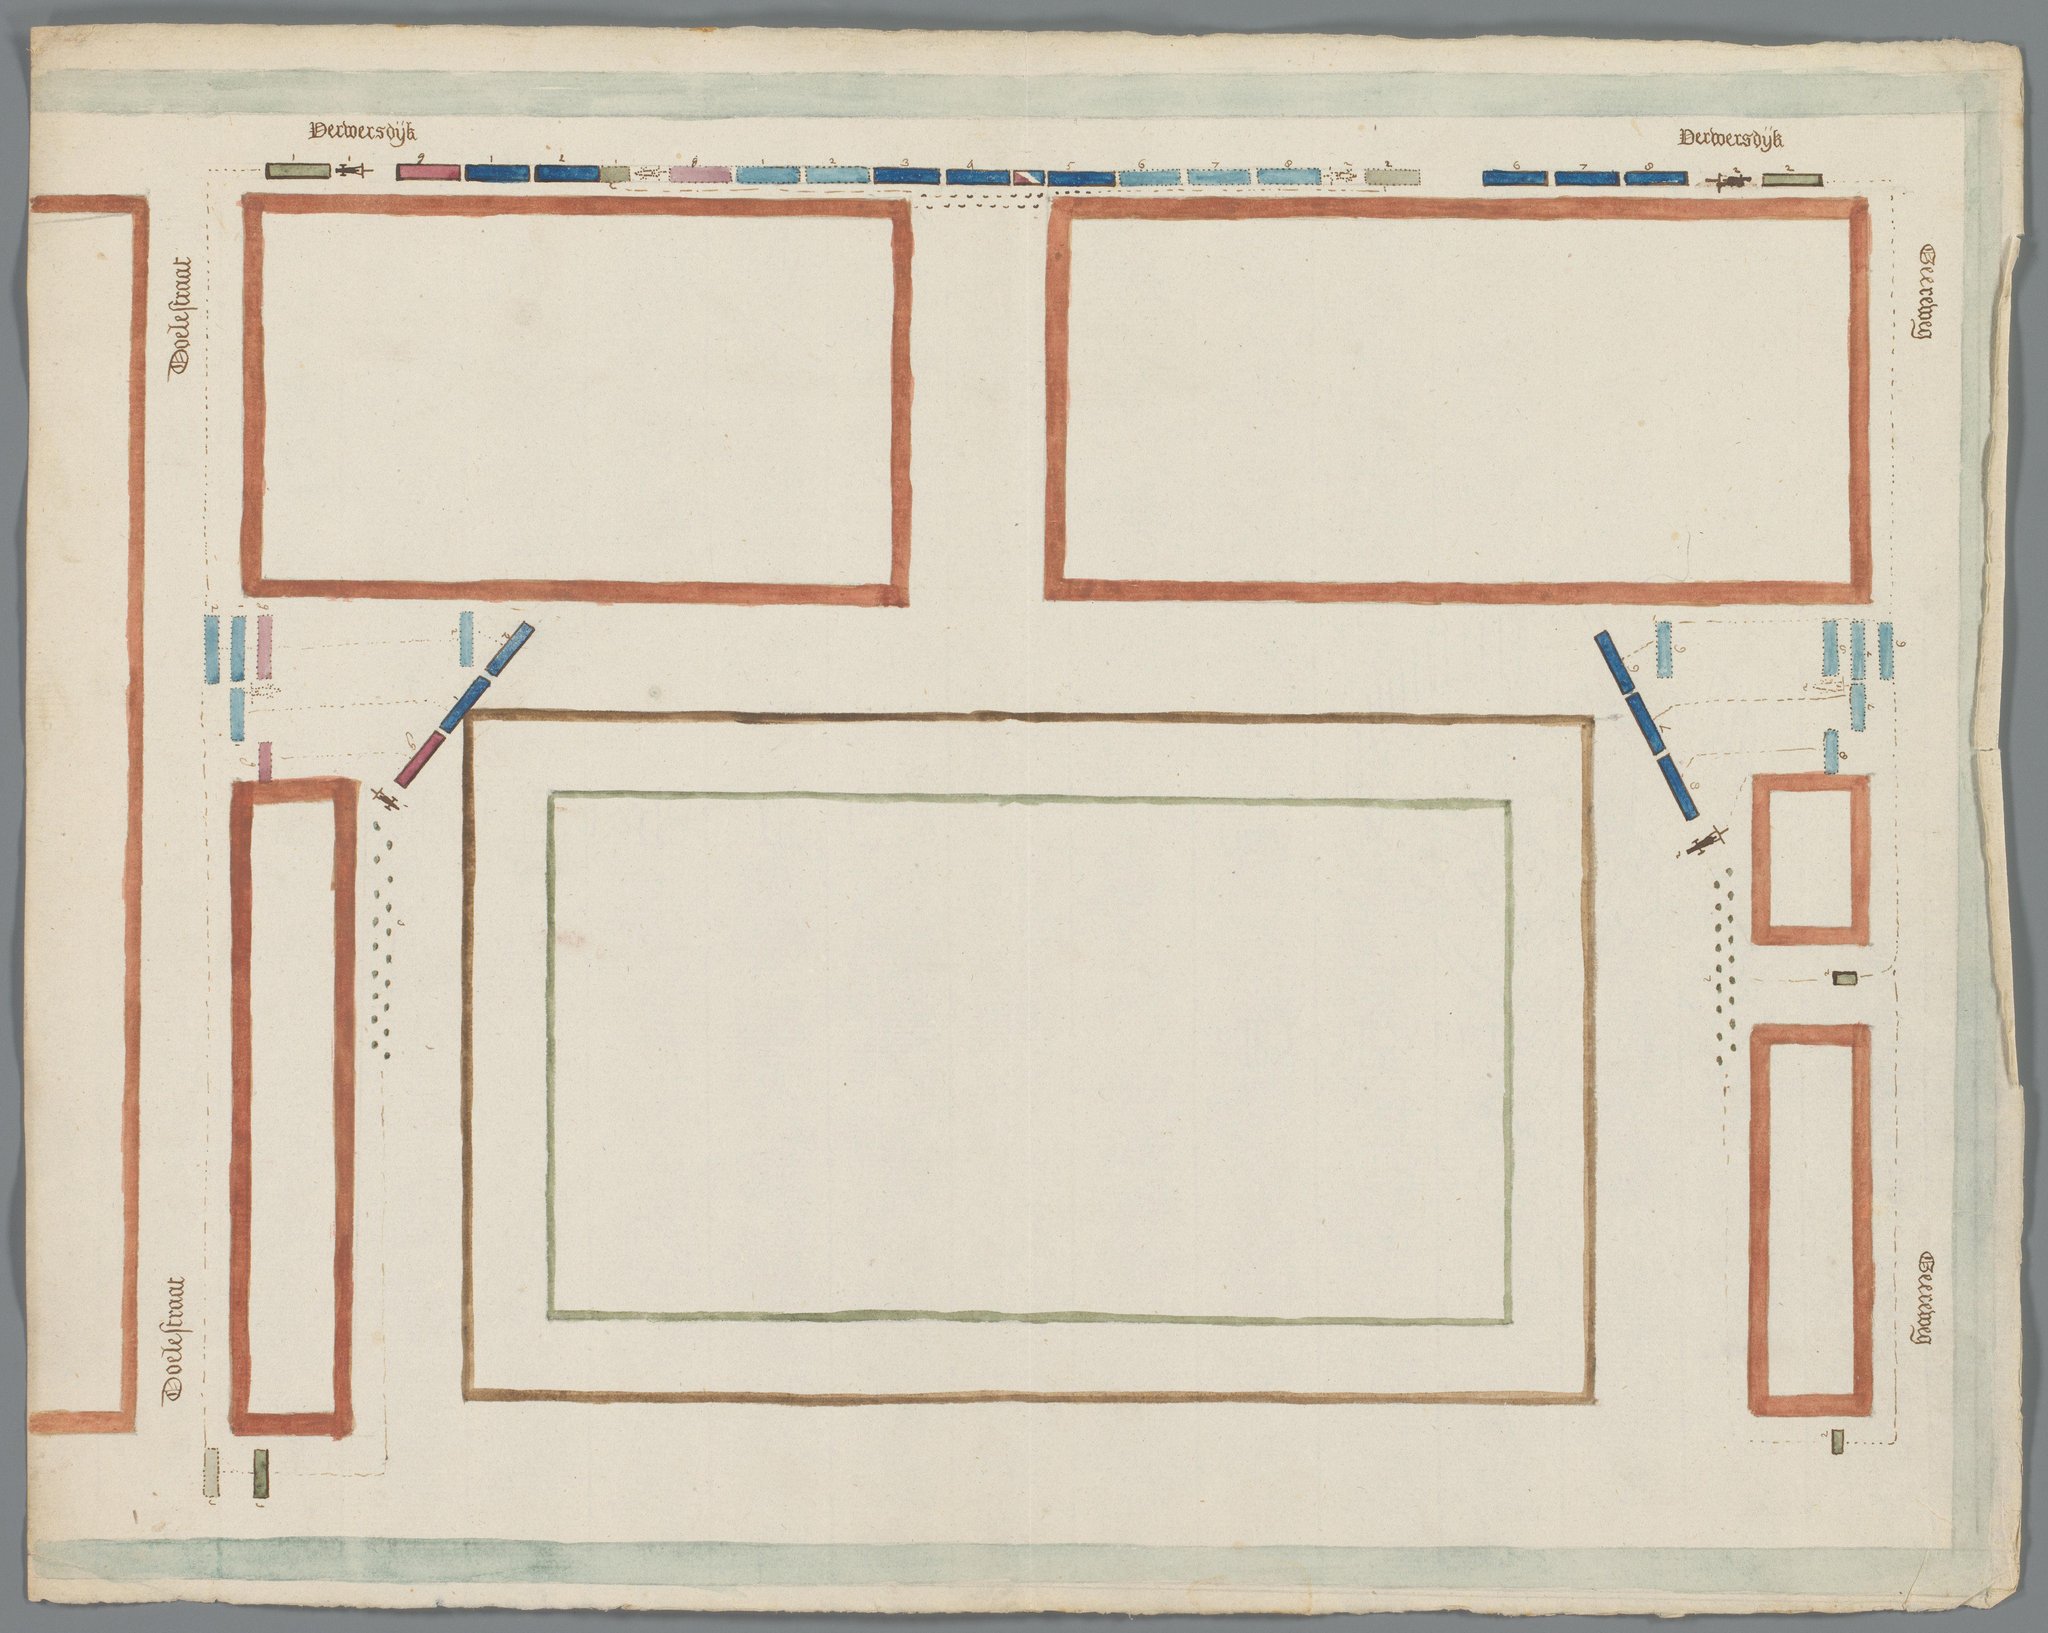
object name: drawing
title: Plattegrond met manoeuvres op het Schuttersveld te Delft, ca. 1799-1803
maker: hendrik van der poth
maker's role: draughtsman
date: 1799-1803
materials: paper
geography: netherlands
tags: manoeuvre ~ military training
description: Plattegrond van de manoeuvres of evoluties van de troepen van de Gewapende Burgermacht op het Schuttersveld langs de Verwersdijk te Delft, ca. 1799-1803.